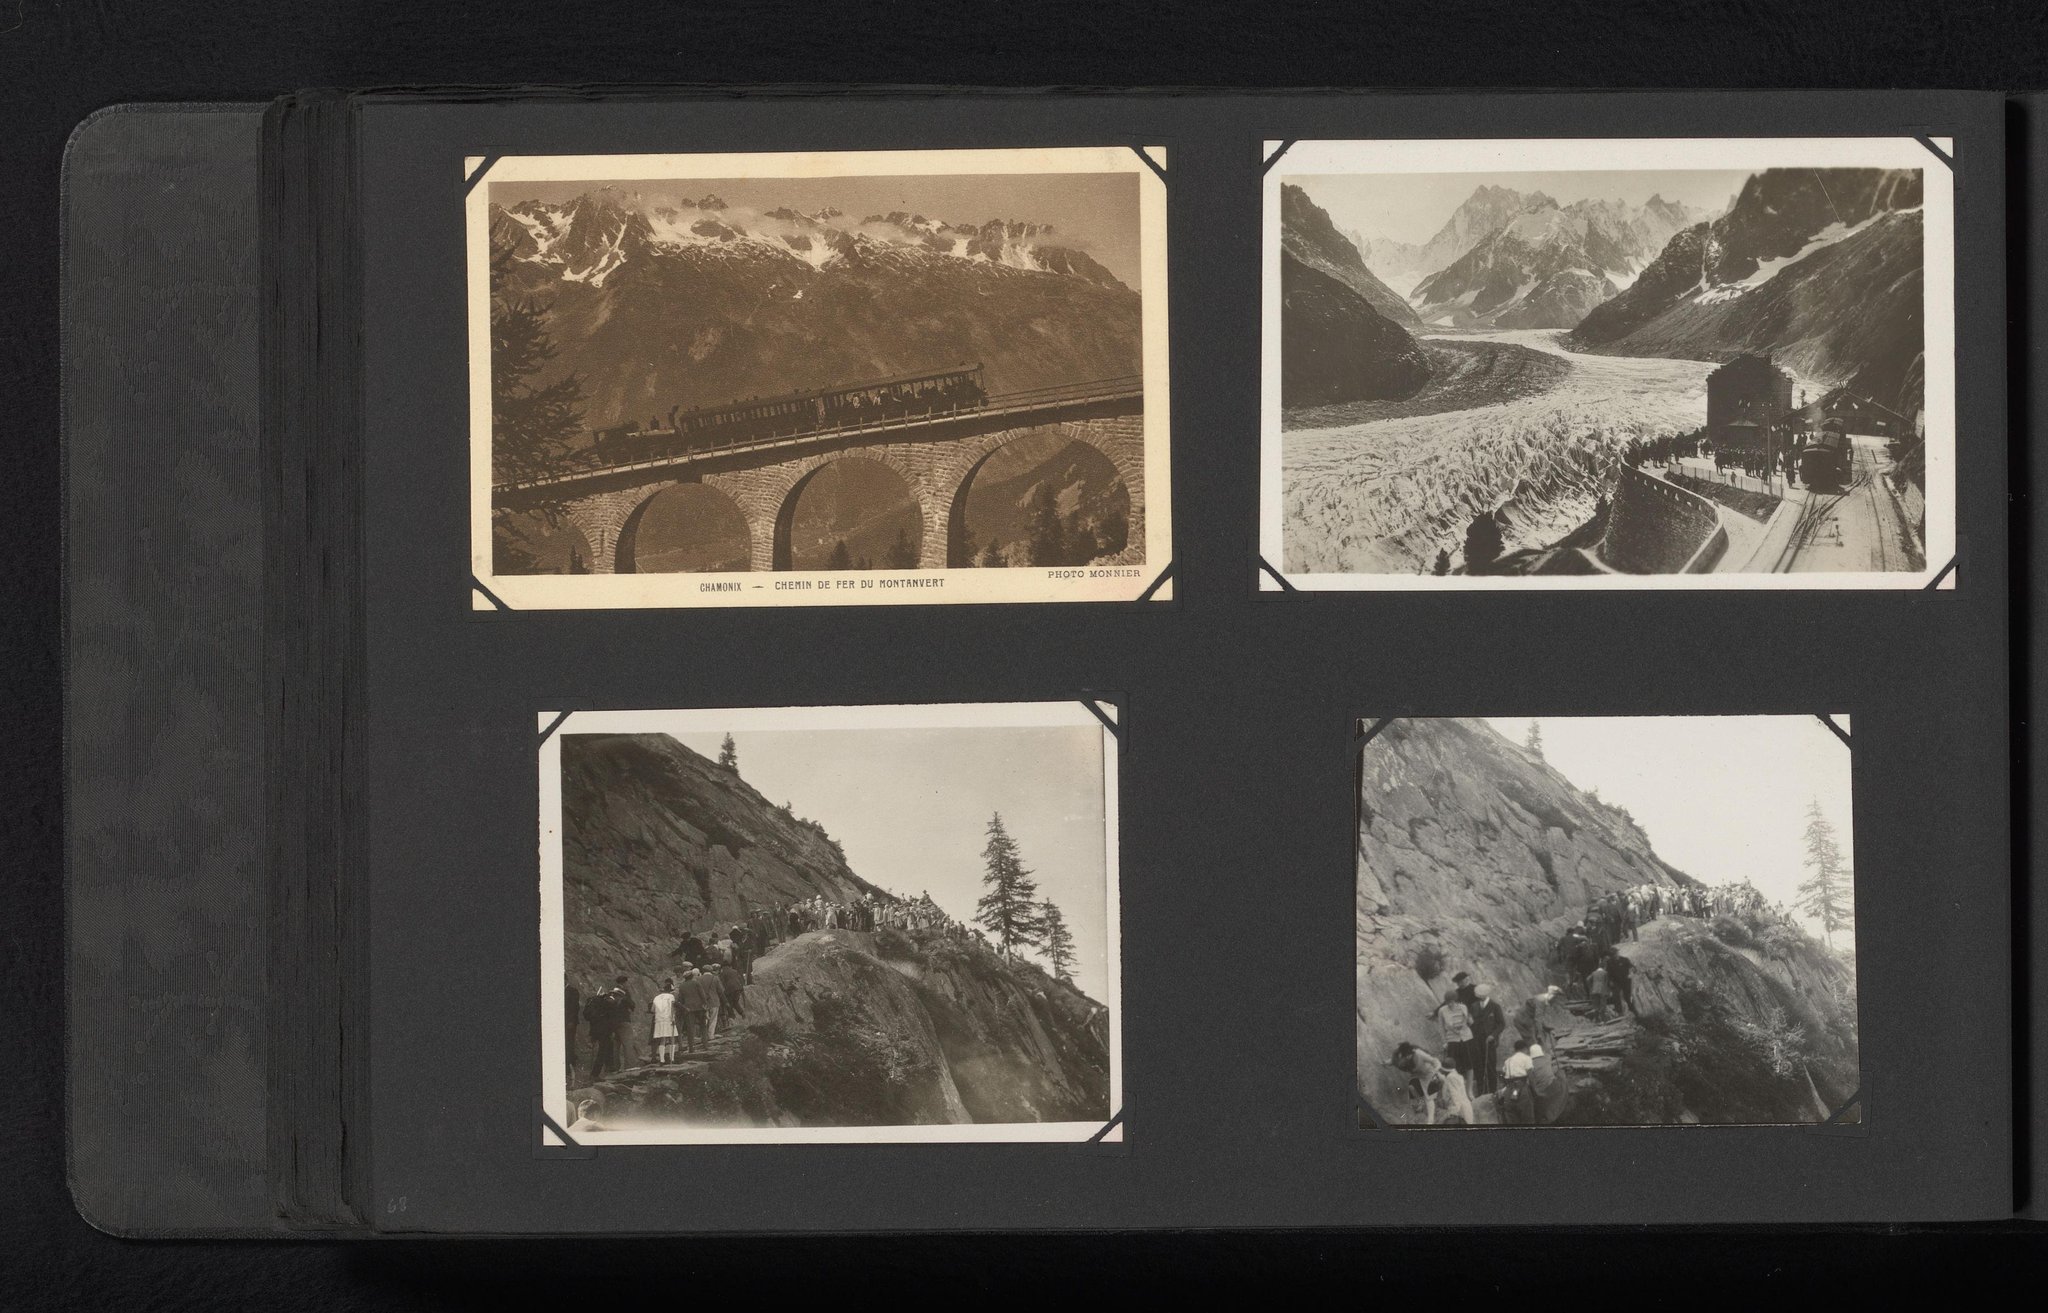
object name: photograph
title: Drie foto's en een fotomechanische prentbriefkaart van toeristen in de Alpen bij Chamonix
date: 1908-1929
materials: paper, cardboard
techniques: gelatin silver print, photoaquatint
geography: chamonix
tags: tourism, rack railway, glacier, mountains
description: Deze foto's en prent maken deel uit van een album.